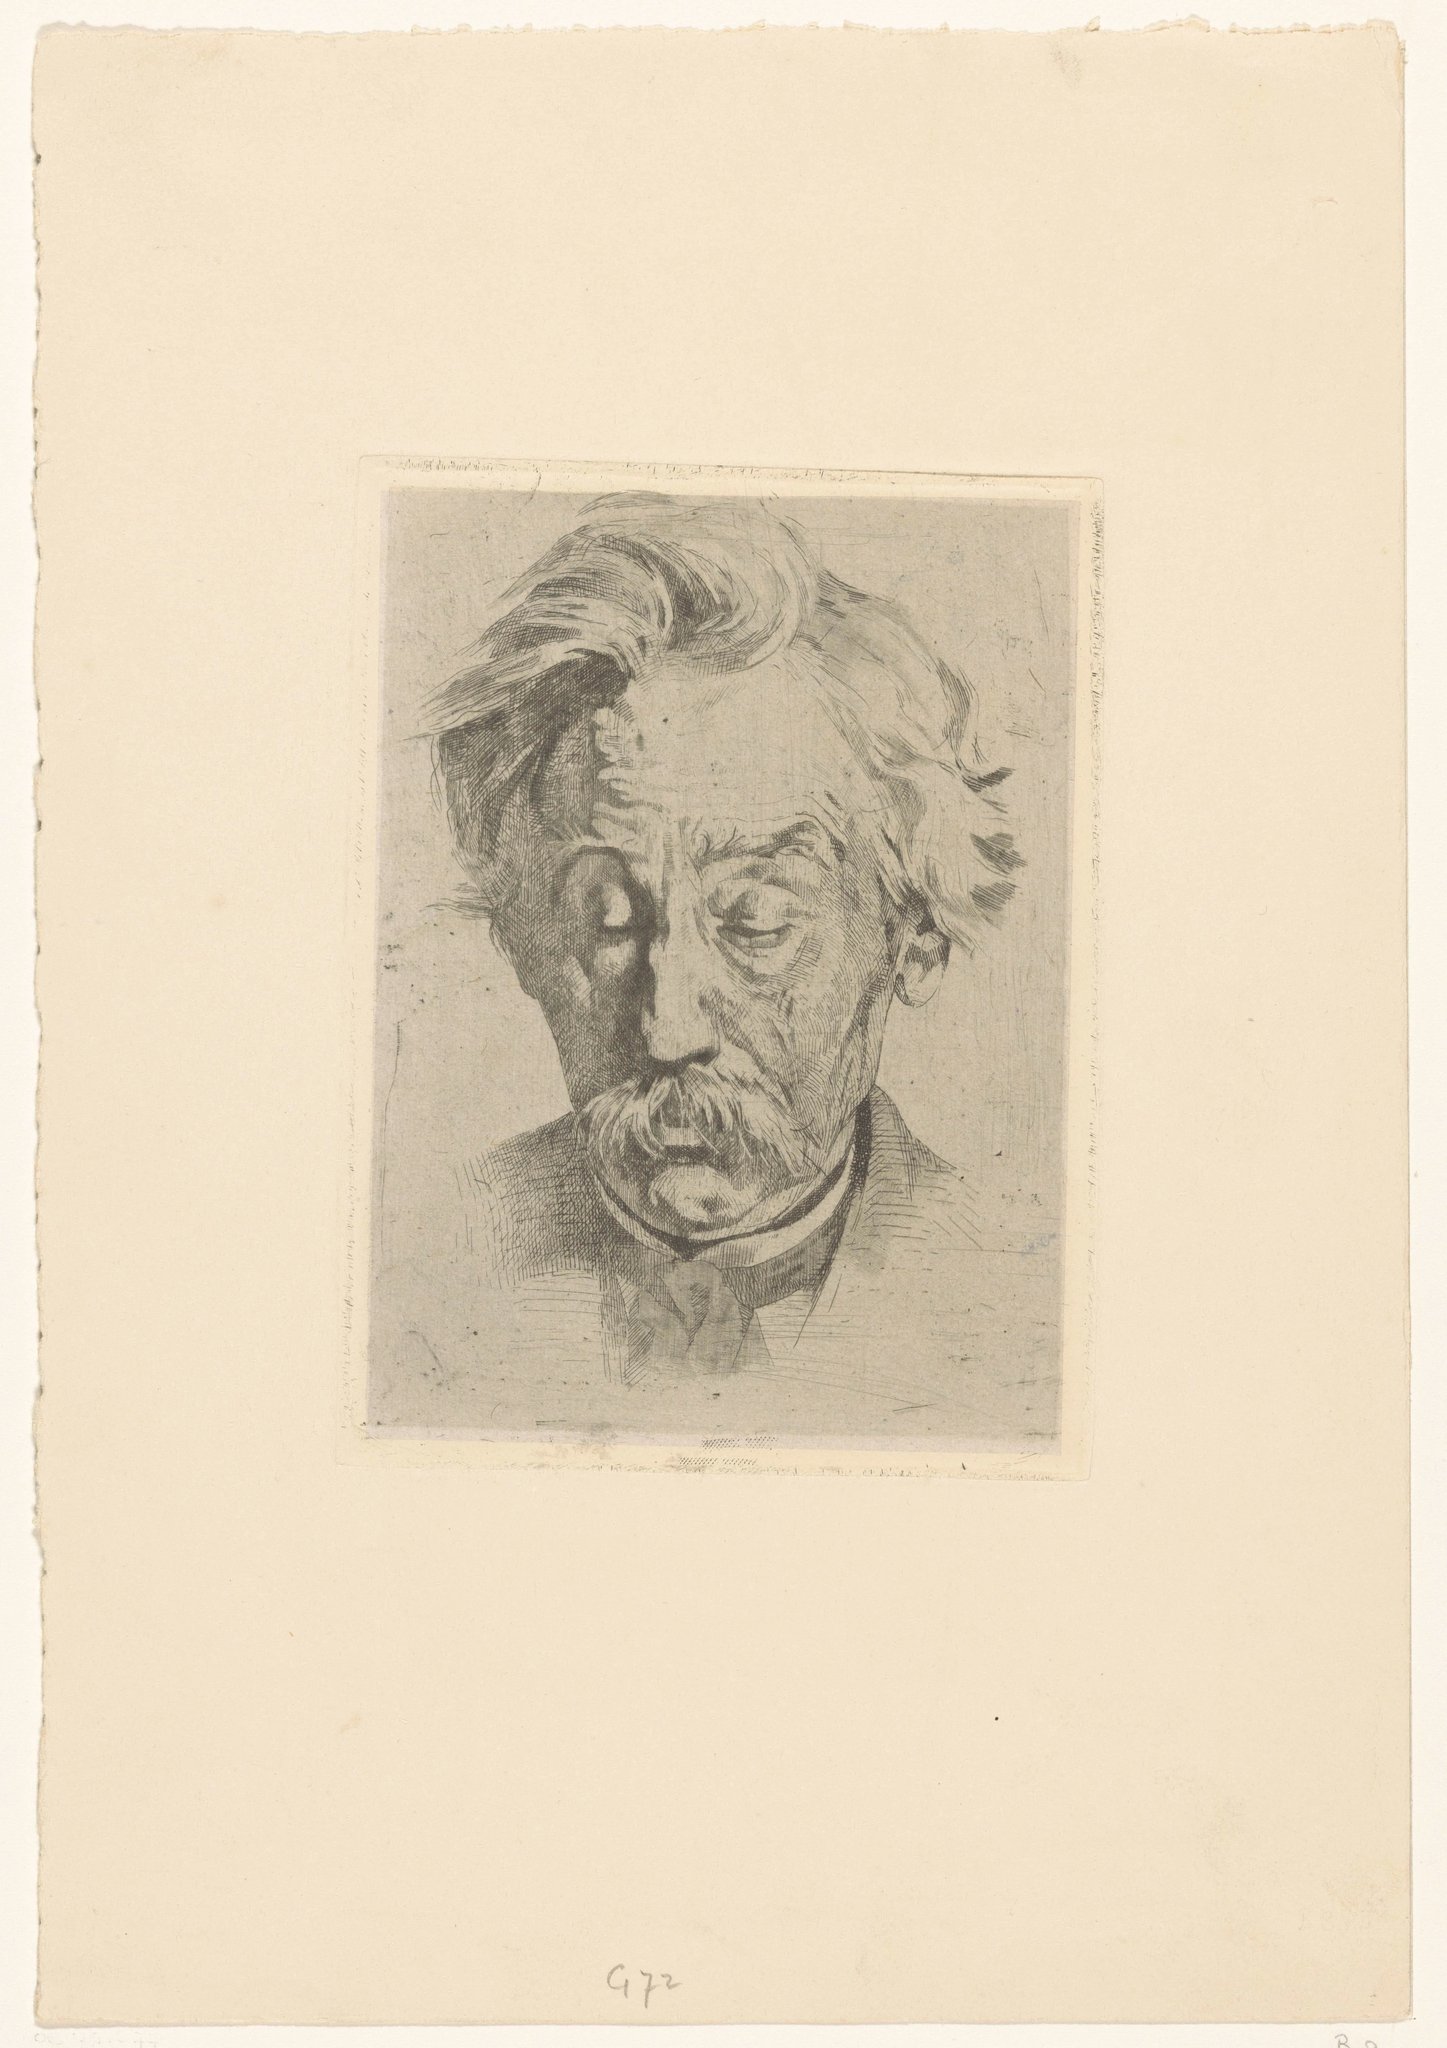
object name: print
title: Portret van dr. Jacob Christiaan Muller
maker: willem witsen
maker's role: draughtsman, painter, print maker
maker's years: 1860-1923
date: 1884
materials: paper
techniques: etching, intaglio, roulette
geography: ewijkshoeve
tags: historical persons